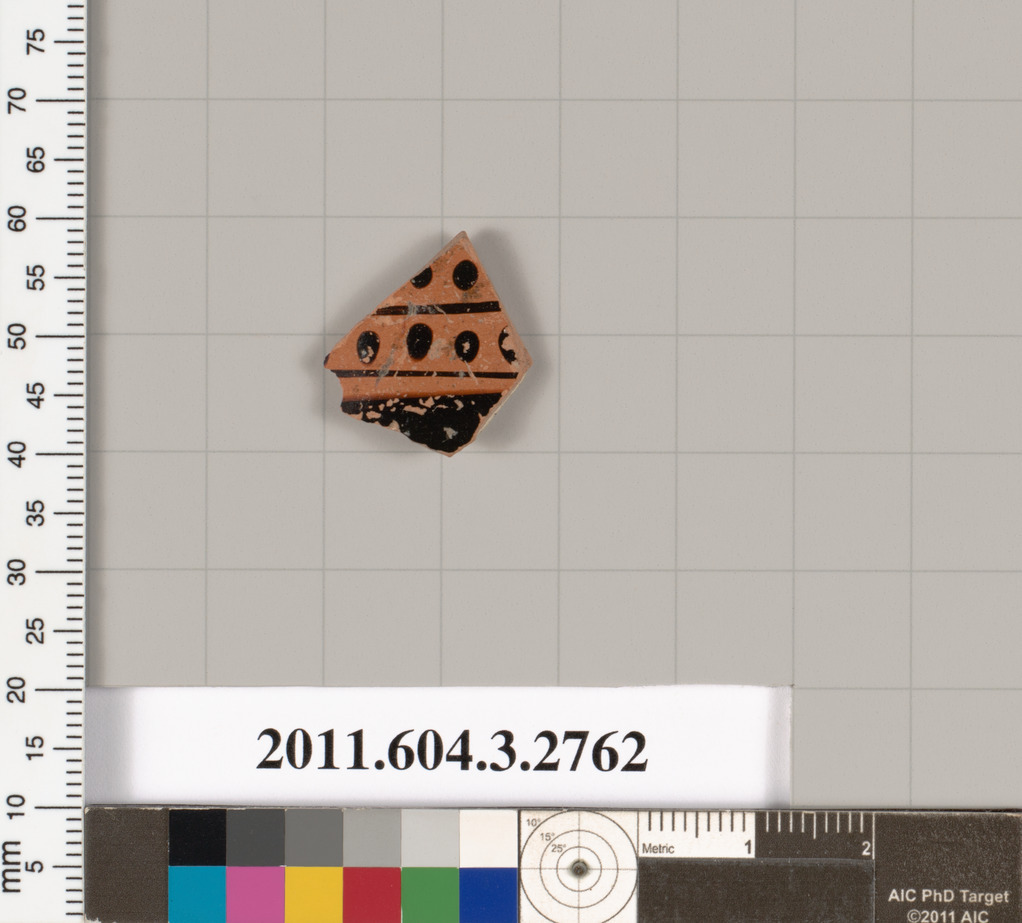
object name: chou fragment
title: Terracotta fragment of an oinochoe: chous (jug)?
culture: greek, attic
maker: dot ivy group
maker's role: artist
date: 525-501 BCE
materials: terracotta